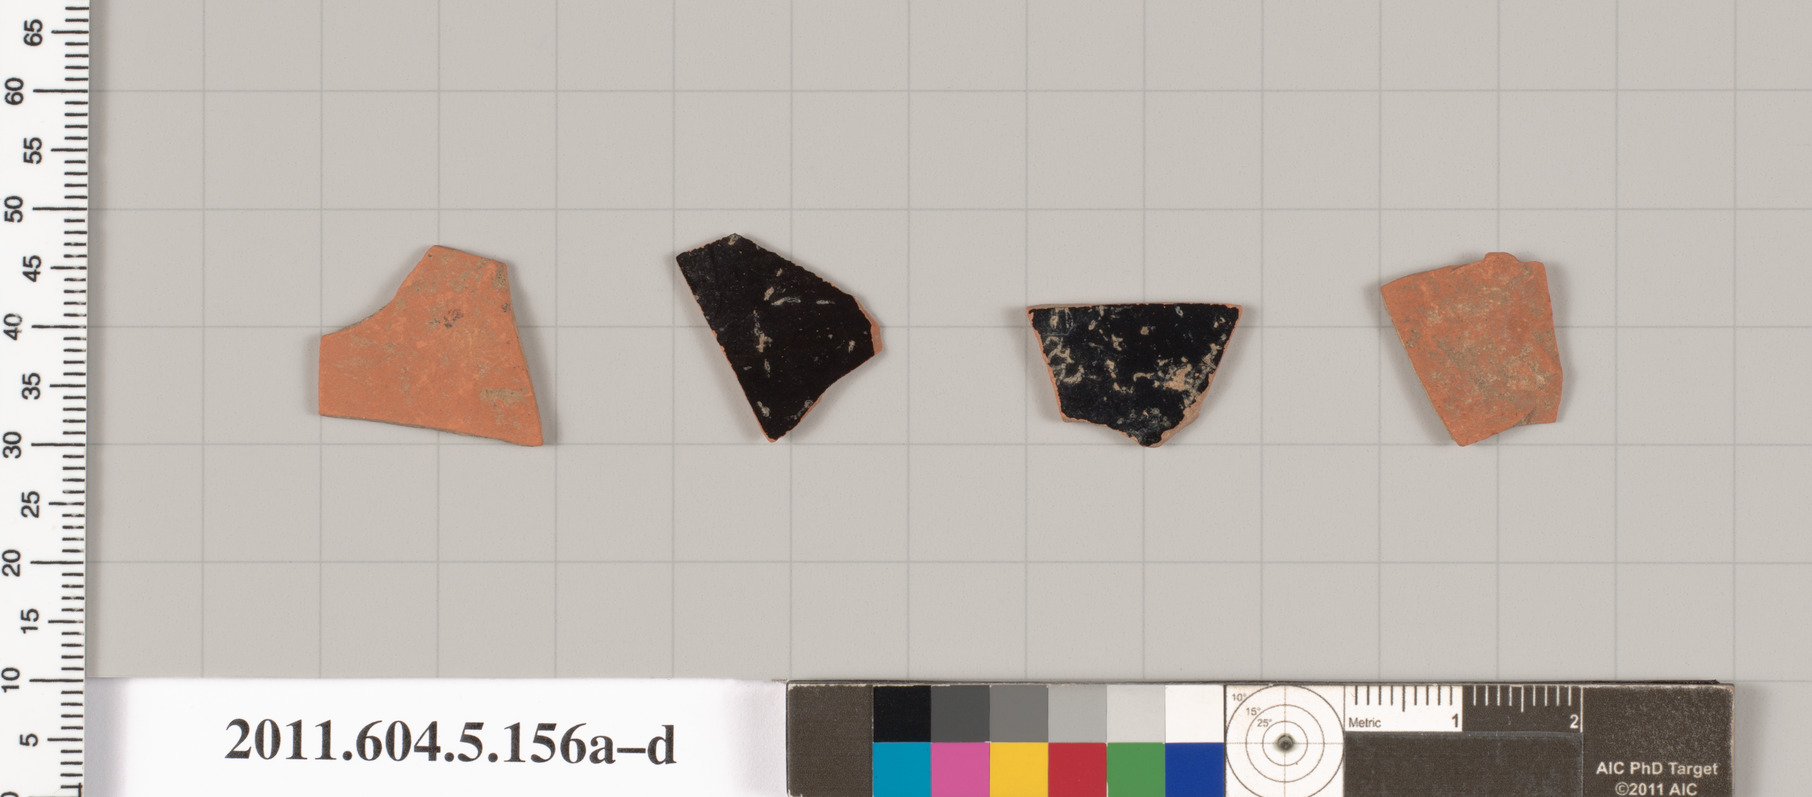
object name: kylix fragment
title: Terracotta fragments of kylikes (drinking cups)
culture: greek, attic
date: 600-401 BCE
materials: terracotta